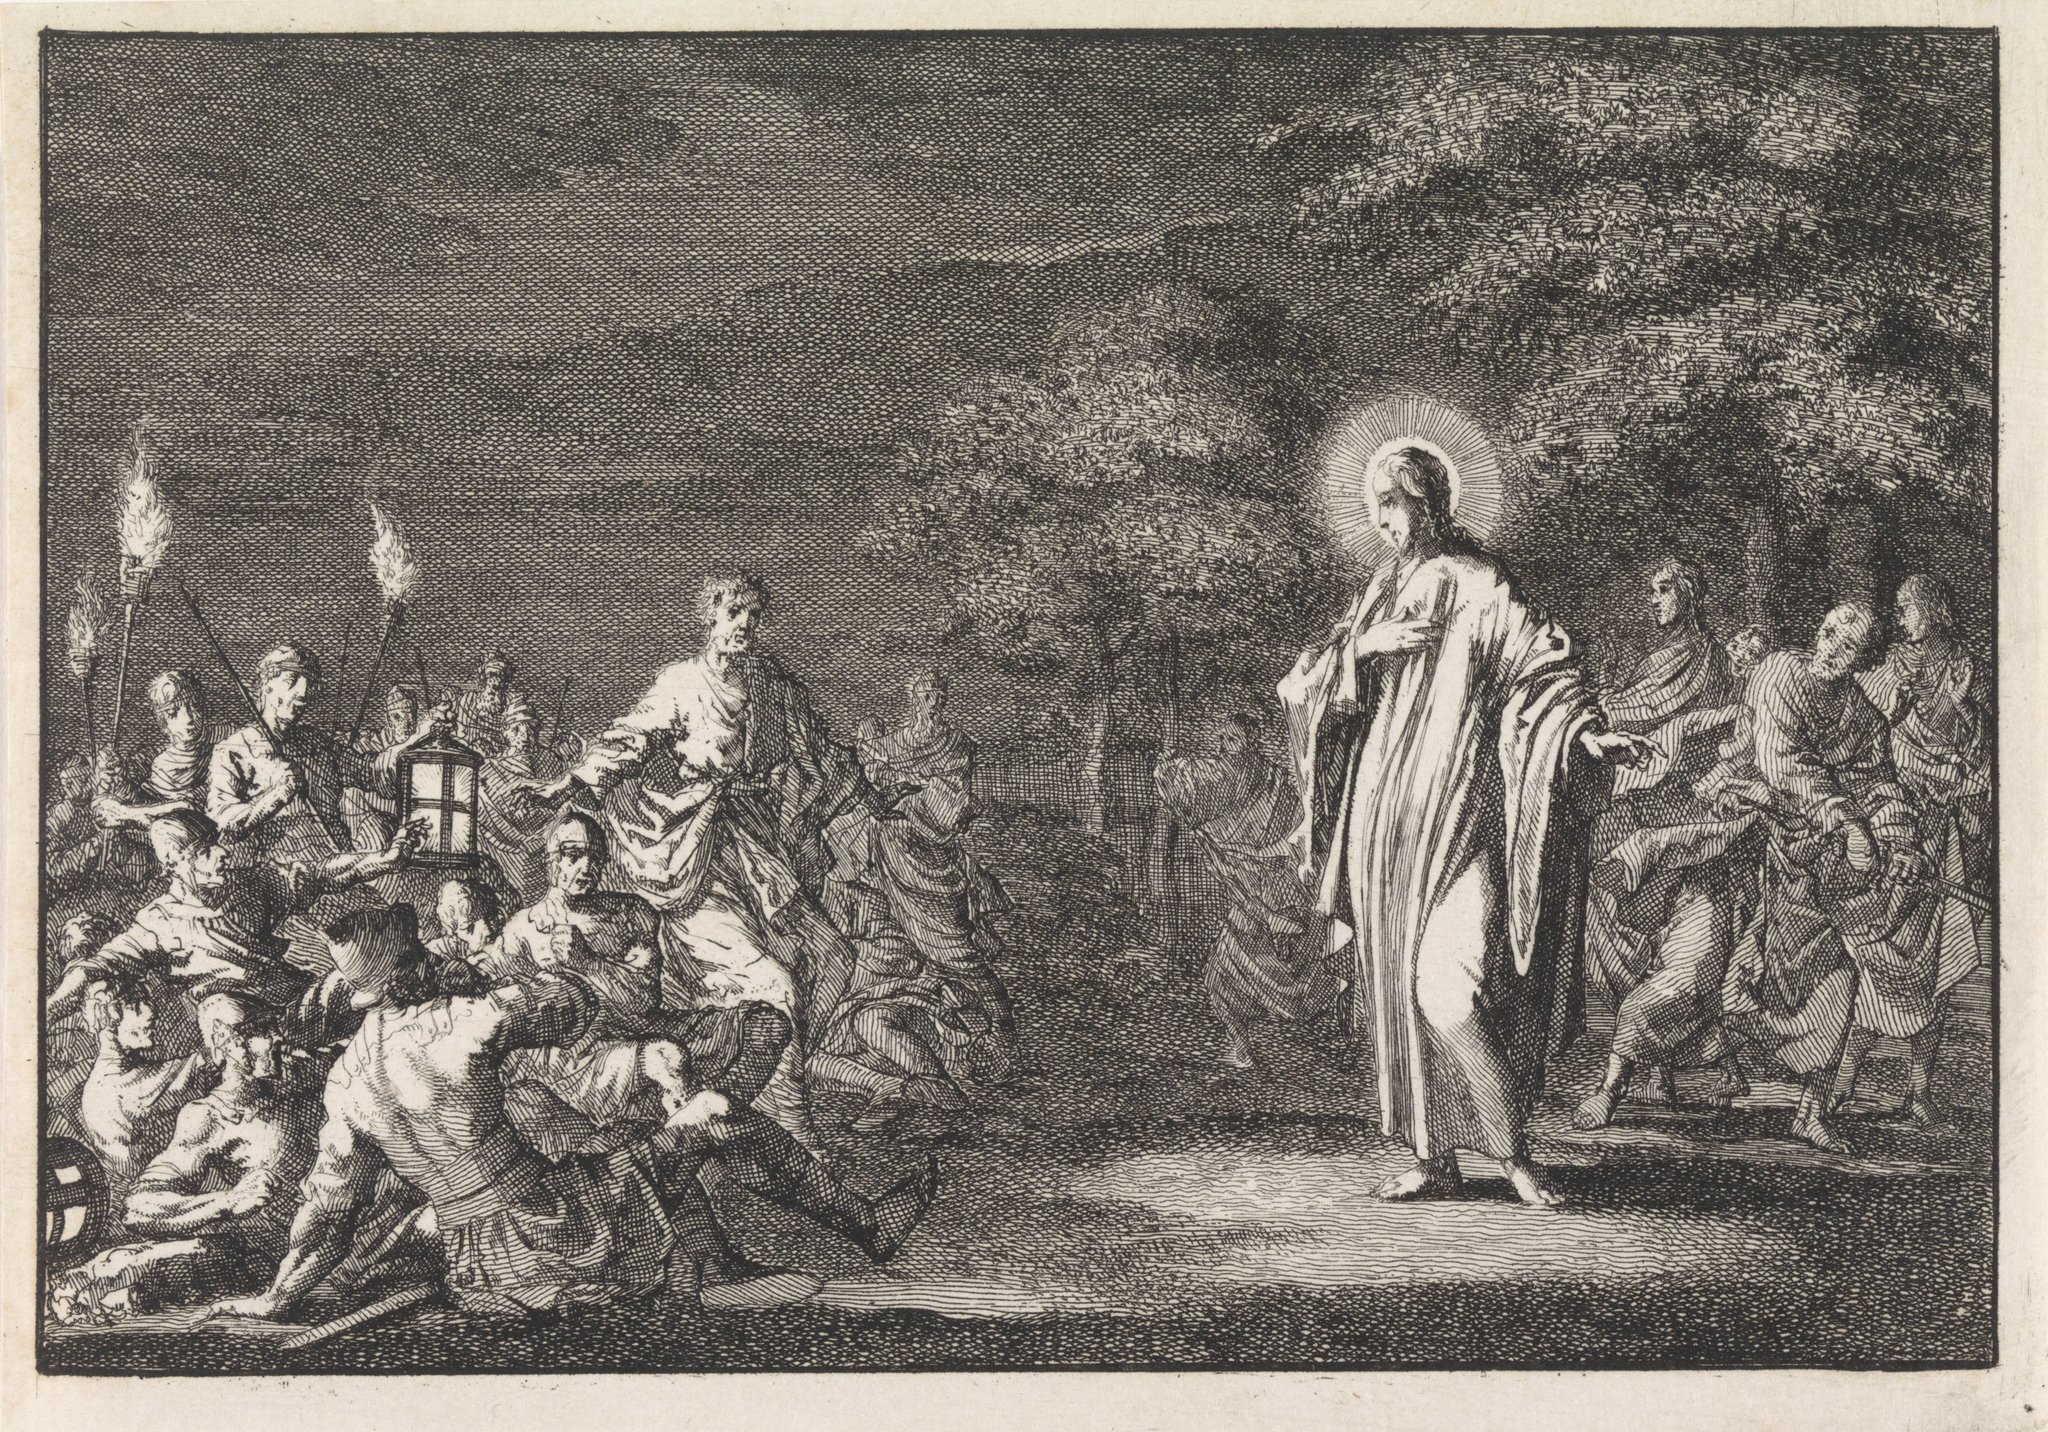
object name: print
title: Arrestatie van Christus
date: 1703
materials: paper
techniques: etching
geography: amsterdam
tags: the arrest of christ ~ garden of gethsemane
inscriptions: collector's mark: Lugt 2228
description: Proefdruk van een boekillustratie voor David Martin. Historie des Ouden en Nieuwen Testaments. Amsterdam, Pieter Mortier, 1703. Deel II. De boekillustraties voor de Mortierbijbel hebben verschillende staten en kopieën, waarbij de chronologische volgorde moeilijk te achterhalen valt. Als boekillustraties werden ze bovendien herhaaldelijk opnieuw gebruikt voor andere boekwerken.